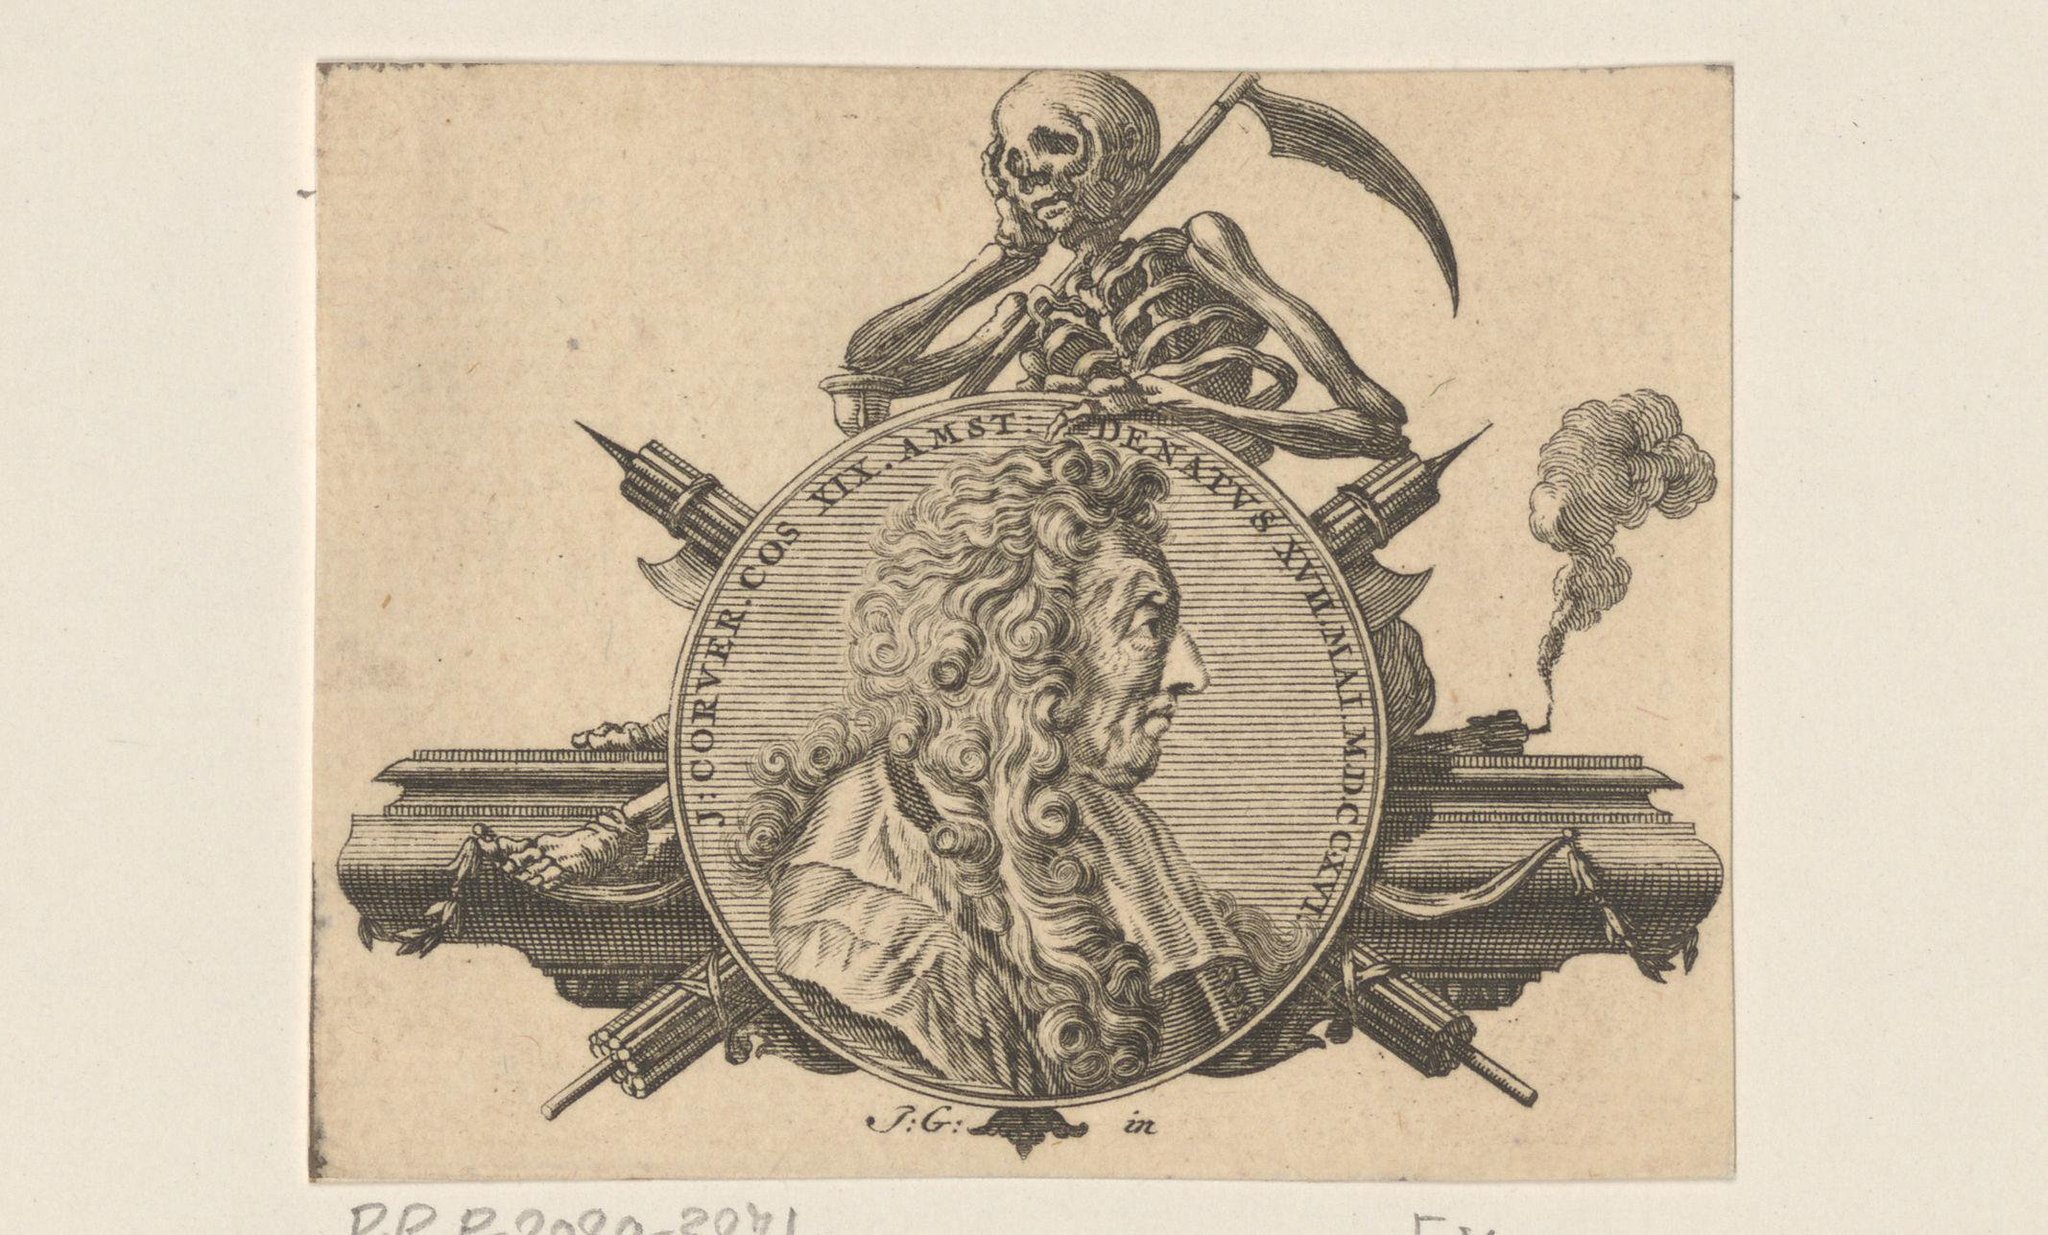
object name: print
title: Medaille met het portret van Joan Corver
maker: jan goeree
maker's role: draughtsman, print maker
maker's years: 1670-1731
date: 1716-1731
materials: paper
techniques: engraving, etching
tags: amsterdam, mayor, historical persons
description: Boven de medaille een skelet met een zeis.